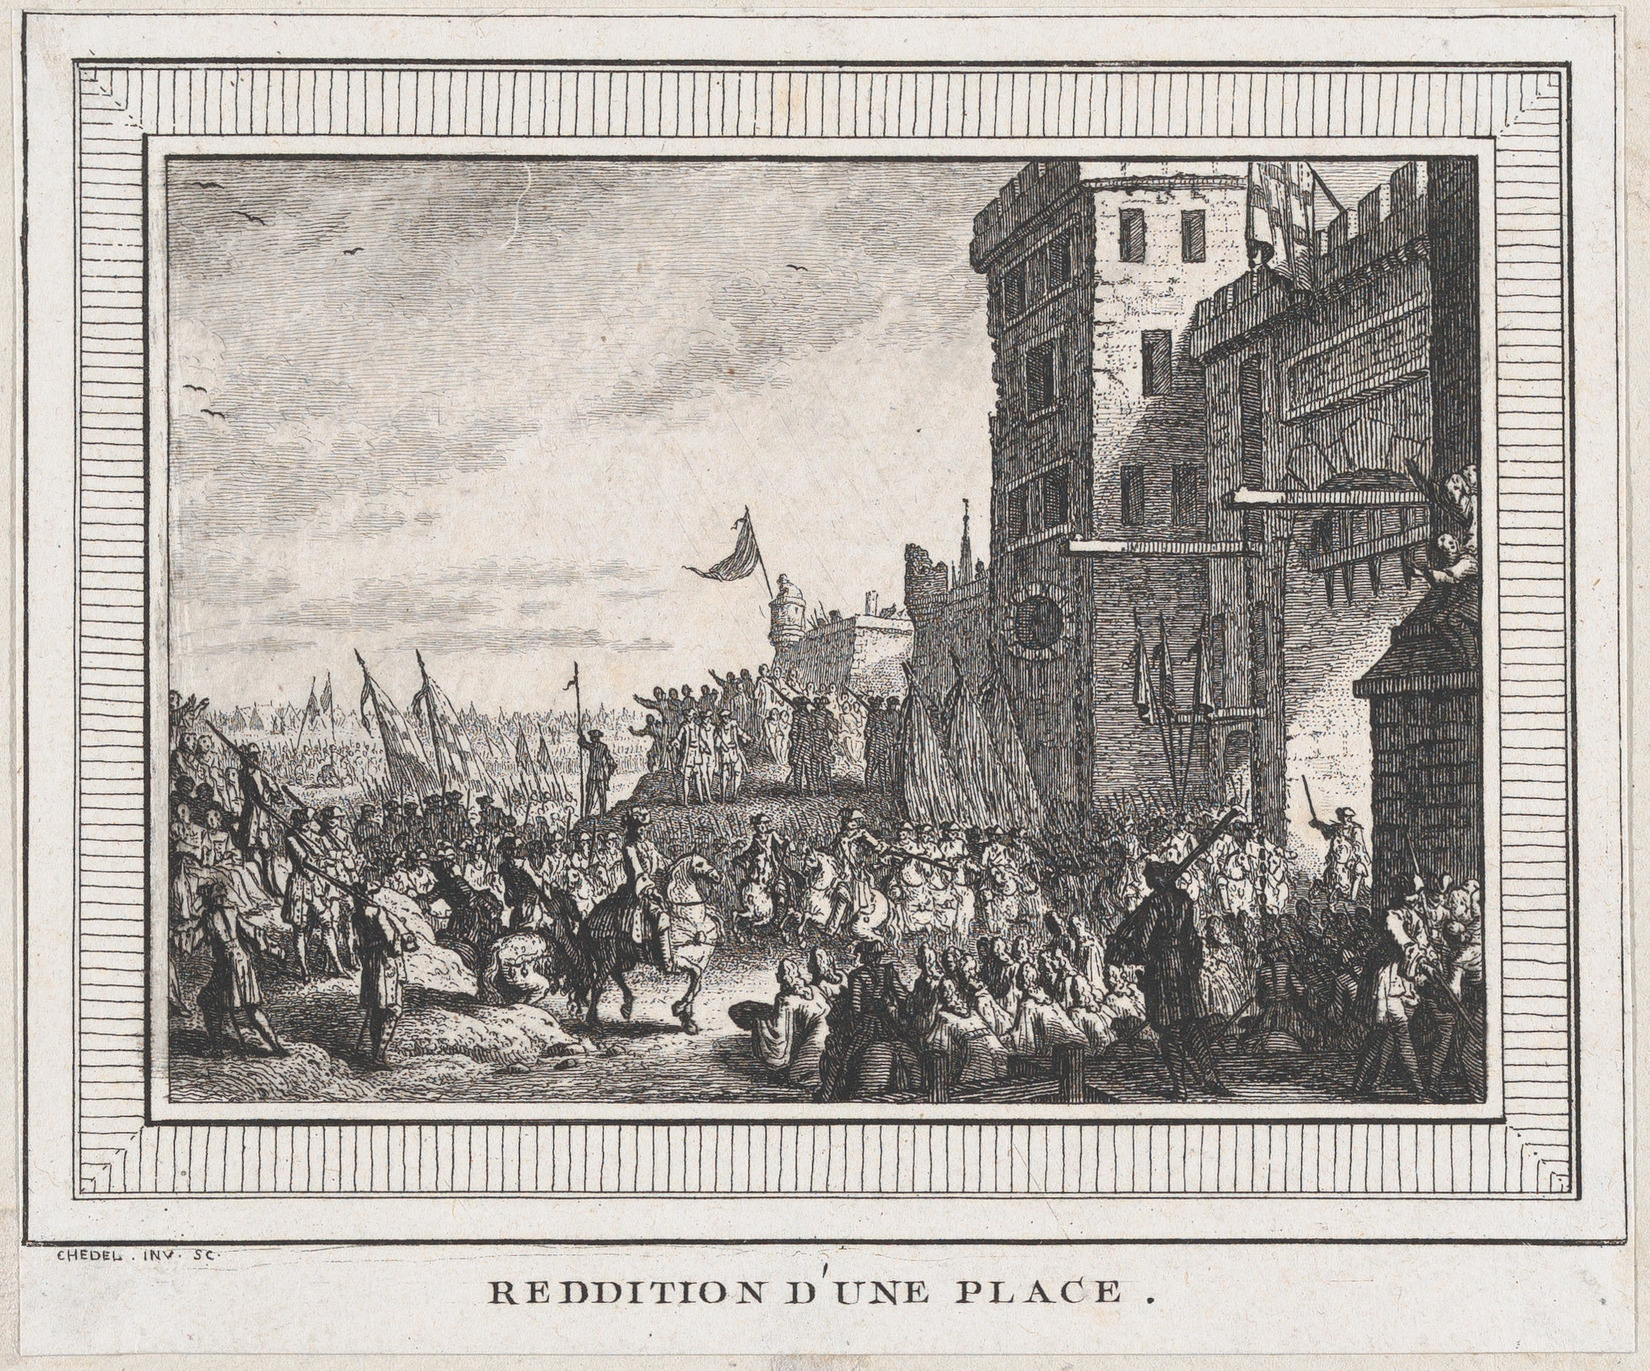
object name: print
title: Reddition d'une place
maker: quentin pierre chedel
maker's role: artist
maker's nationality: french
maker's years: 1705-1763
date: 1701-1800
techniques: etching